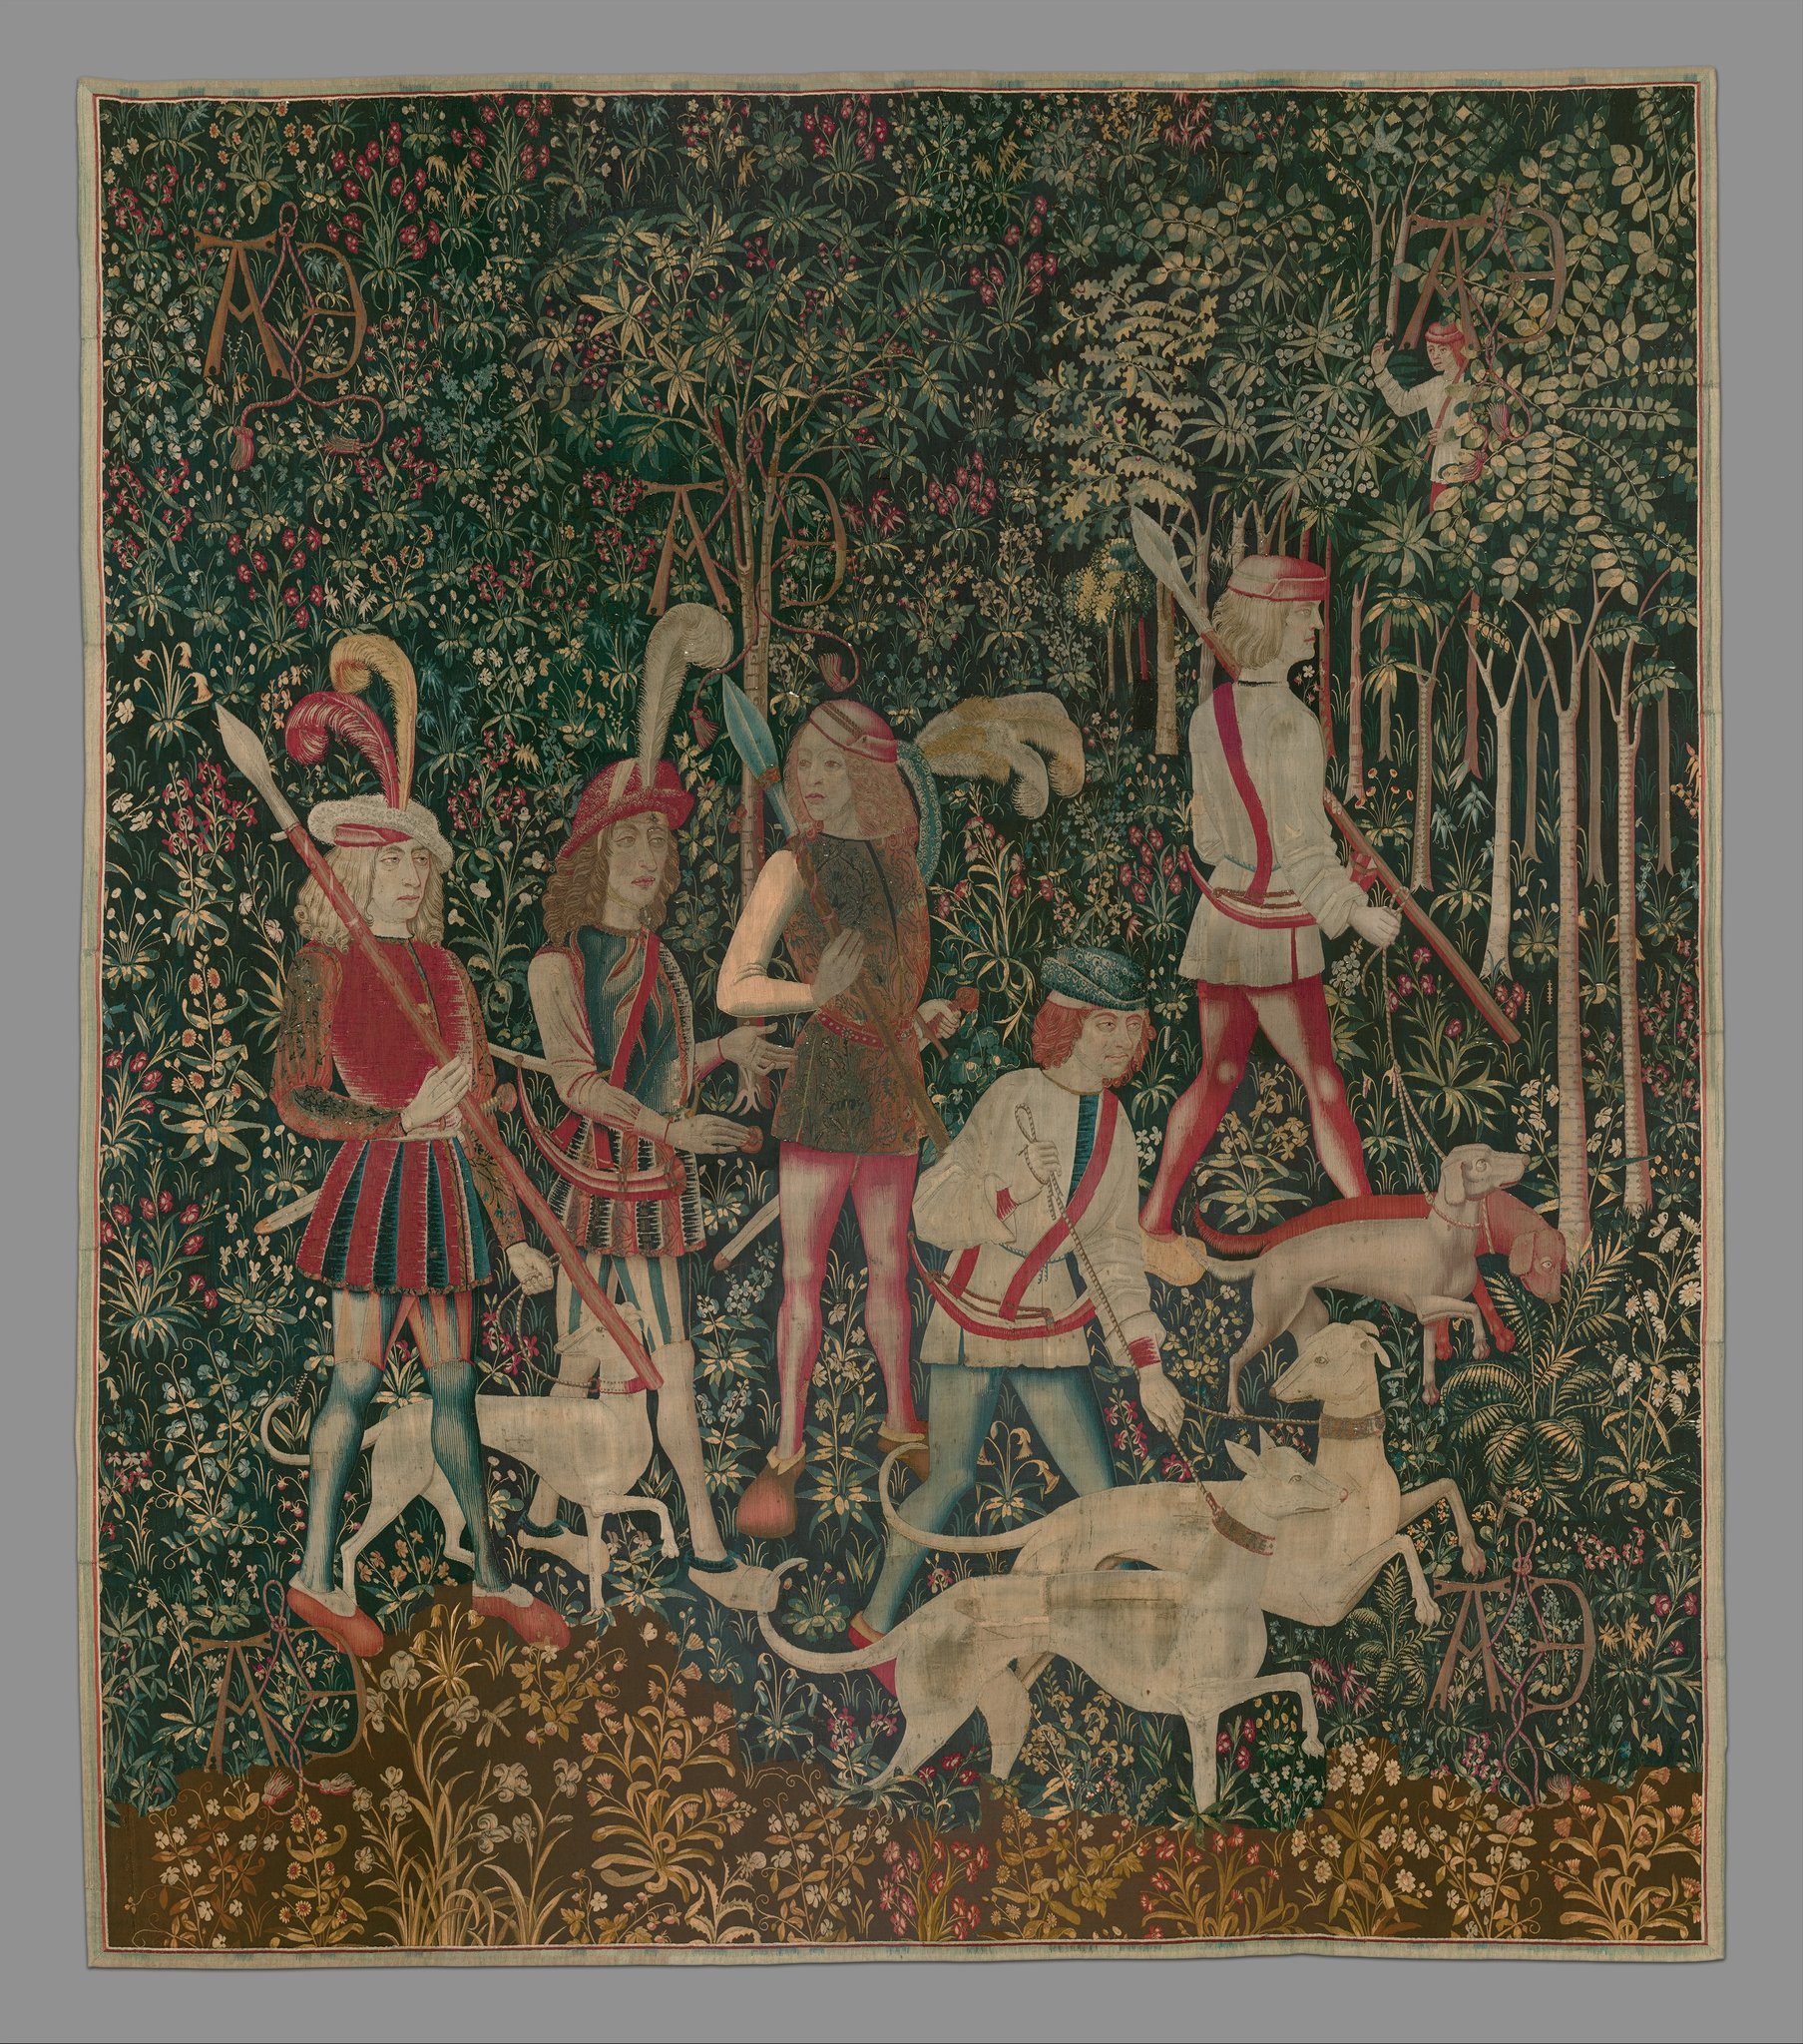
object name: tapestry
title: The Hunters Enter the Woods (from the Unicorn Tapestries)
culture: french or south netherlandish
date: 1495-1505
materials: gilt, silk, silver, wool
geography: netherlands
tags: spears,men,hunting,dogs,flowers,trees